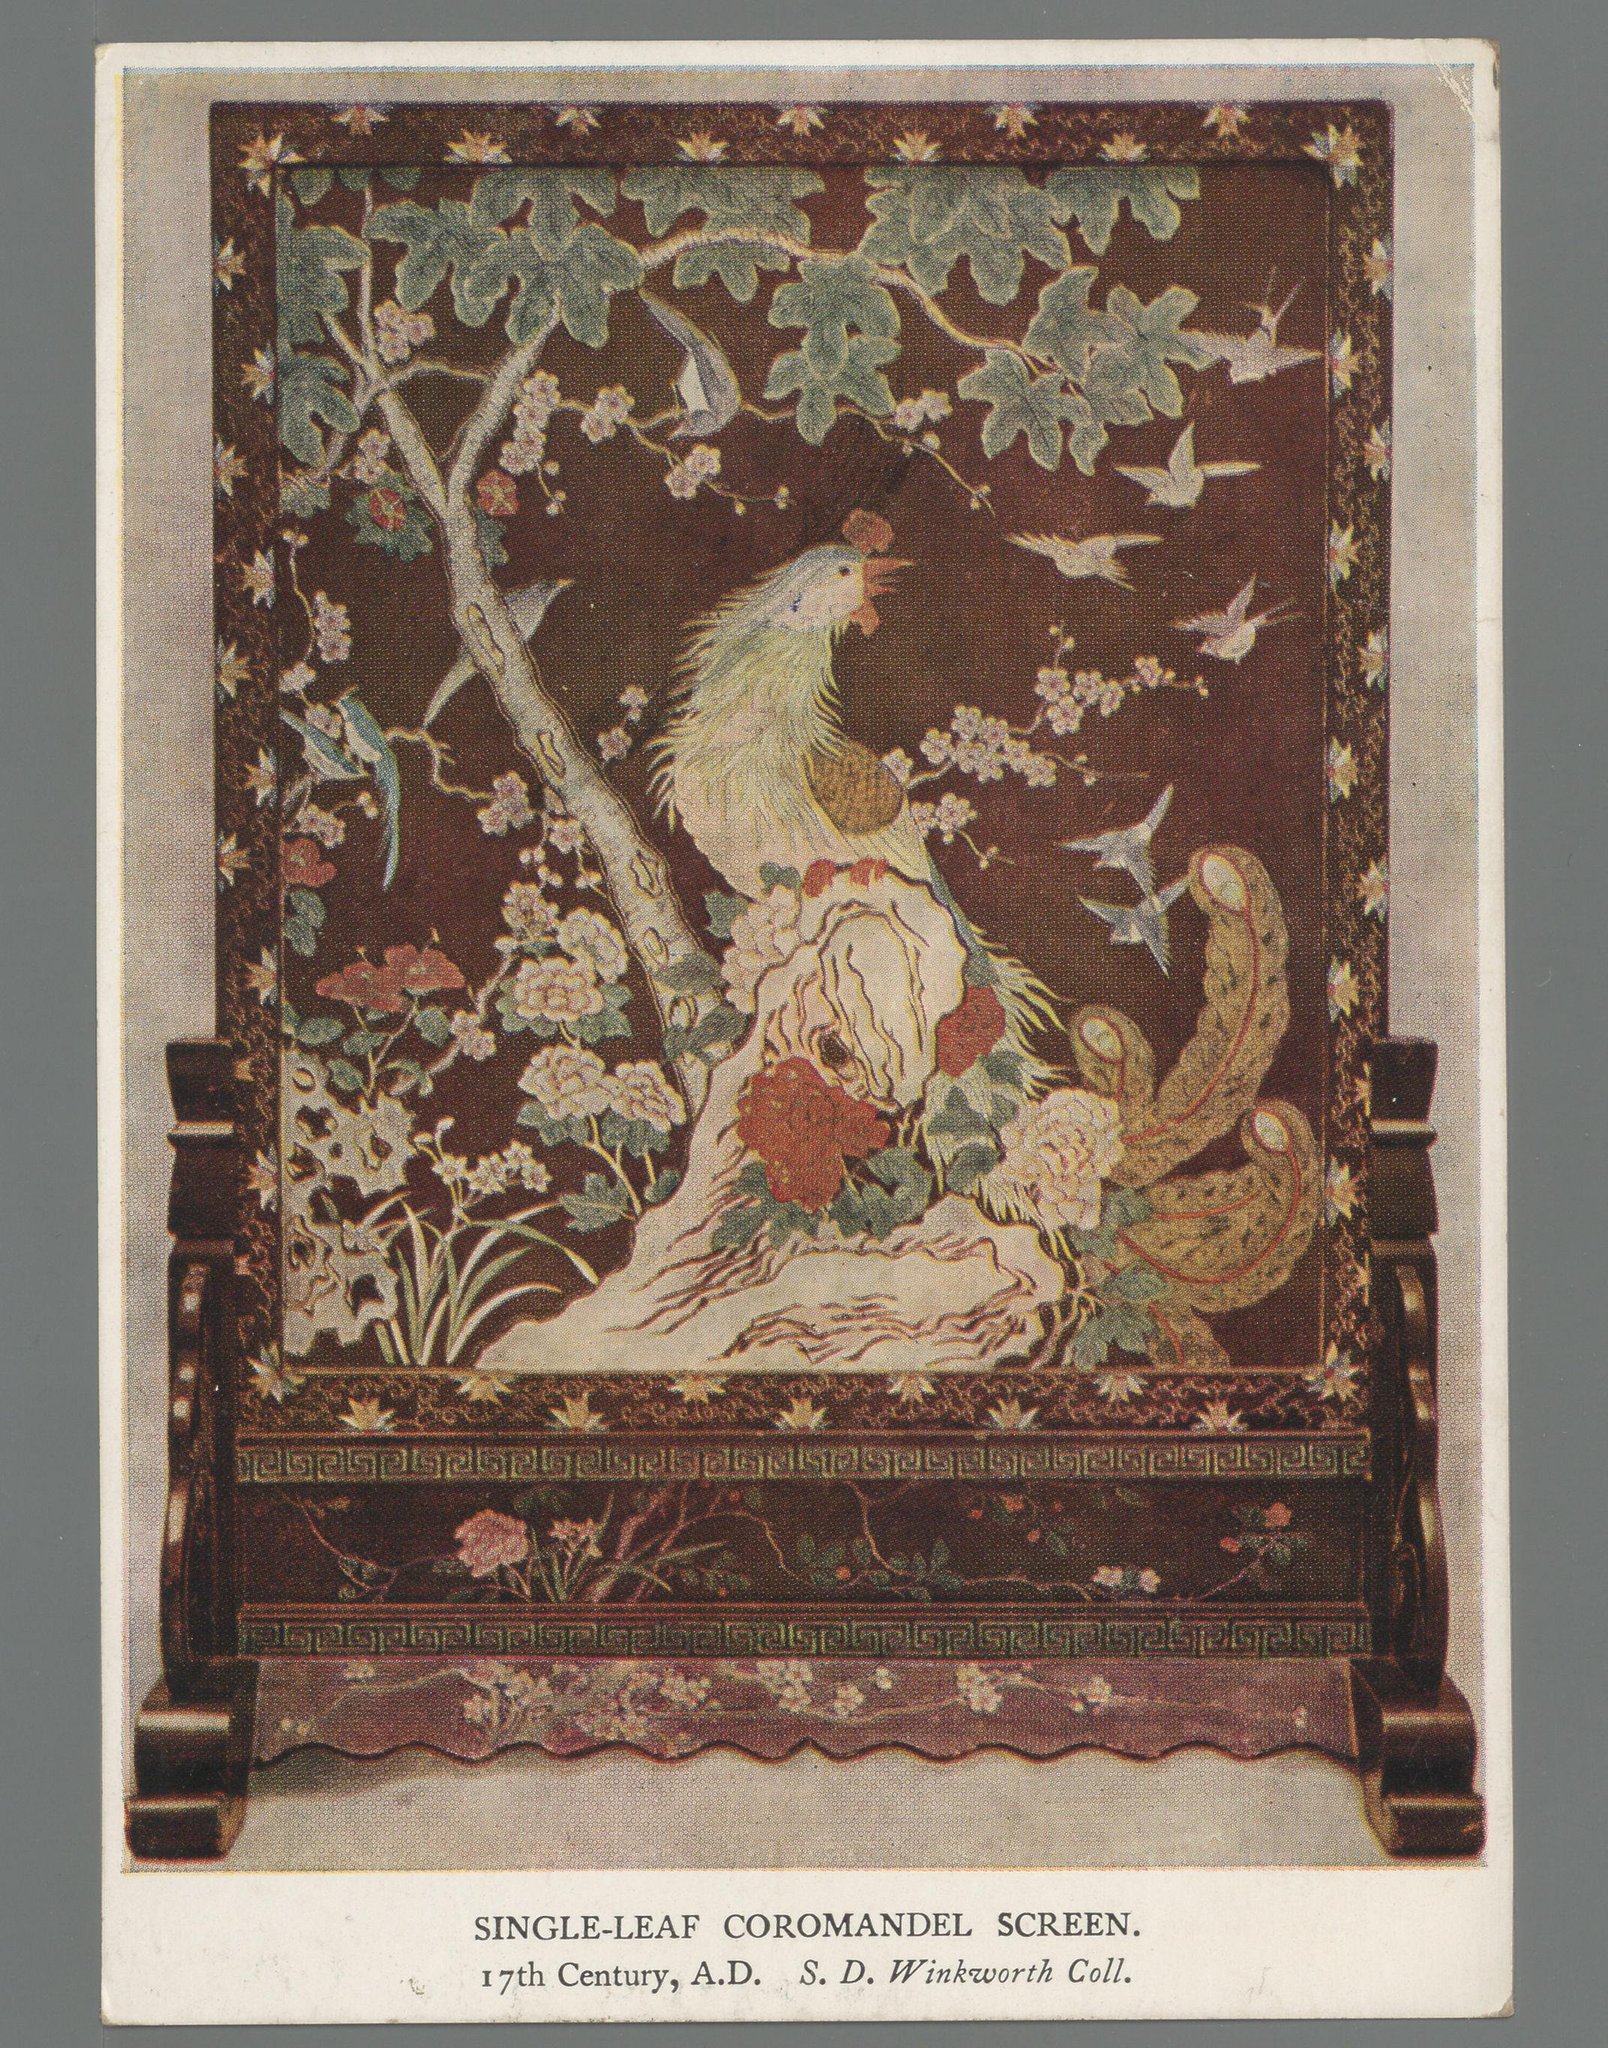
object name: ansichtkaart, prentbriefkaart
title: Single-leaf Coromandel screen. 17th Century, A.D. S.D. Winkworth Coll.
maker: Anonymous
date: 1902-1949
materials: cardboard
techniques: writing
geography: england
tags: draught-screen, permanent exhibition, museum, london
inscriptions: postage stamp